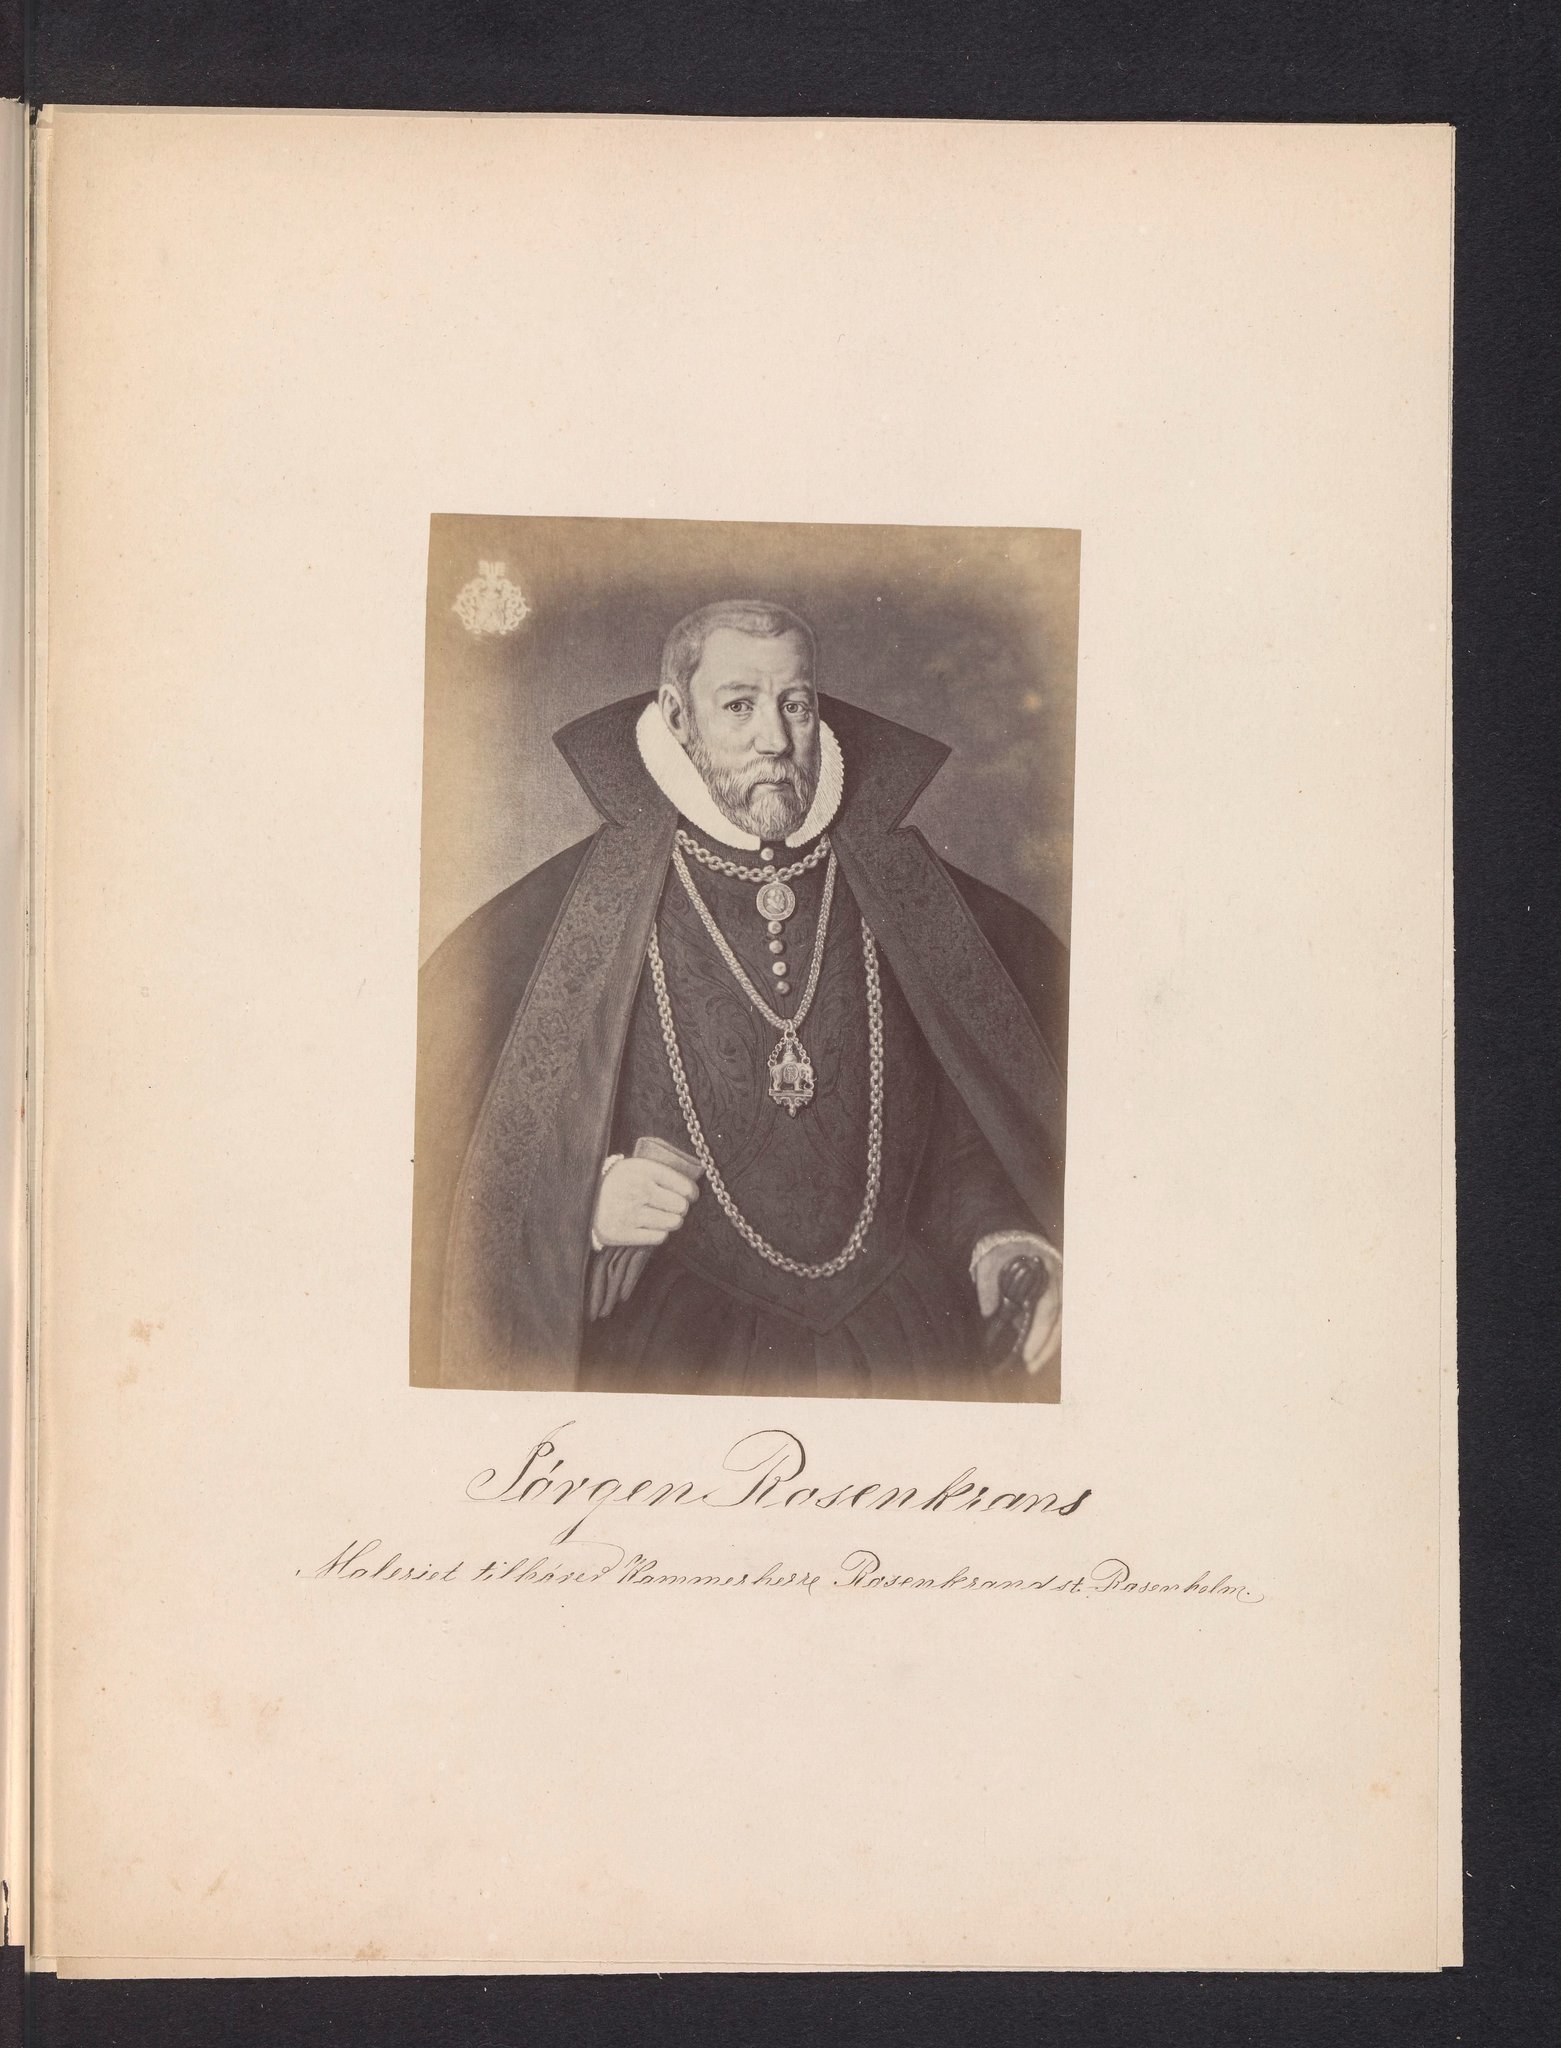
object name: reproduction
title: Fotoreproductie van een schilderij, voorstellende een portret van Jørgen Ottesen Rosenkrantz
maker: julius wulff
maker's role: fotograaf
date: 1858-1862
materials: photographic support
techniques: albumen print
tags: governmental and representative bodies, adult man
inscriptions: inscription: ‘Maleriet tillhører Kammerherre, Baron Rosenkrands til Rosenholm’